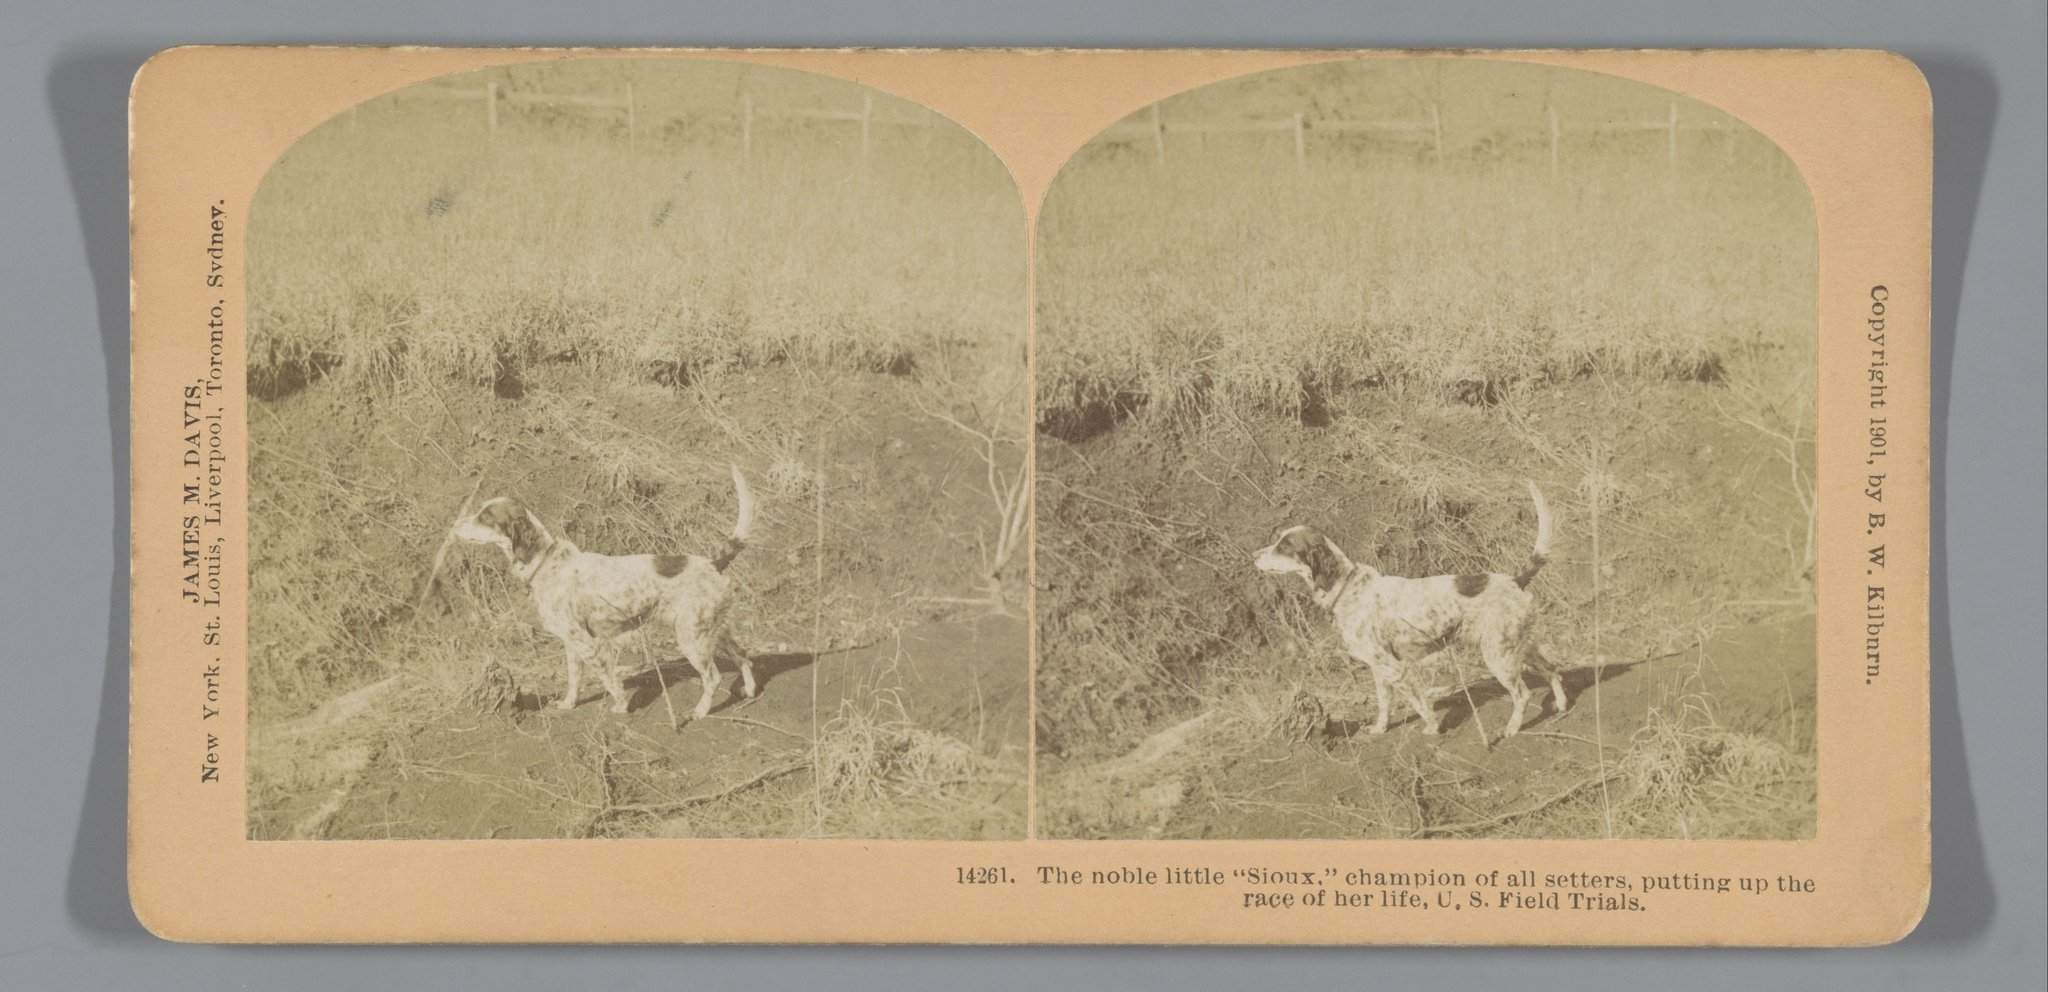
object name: stereograph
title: Sioux tijdens de U.S. Field Trials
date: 1901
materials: cardboard, paper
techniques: albumen print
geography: united states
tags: dogs (racing)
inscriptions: number: ‘14261’, copyright notice: ‘Copyright 1901, by B. W. Kilburn’